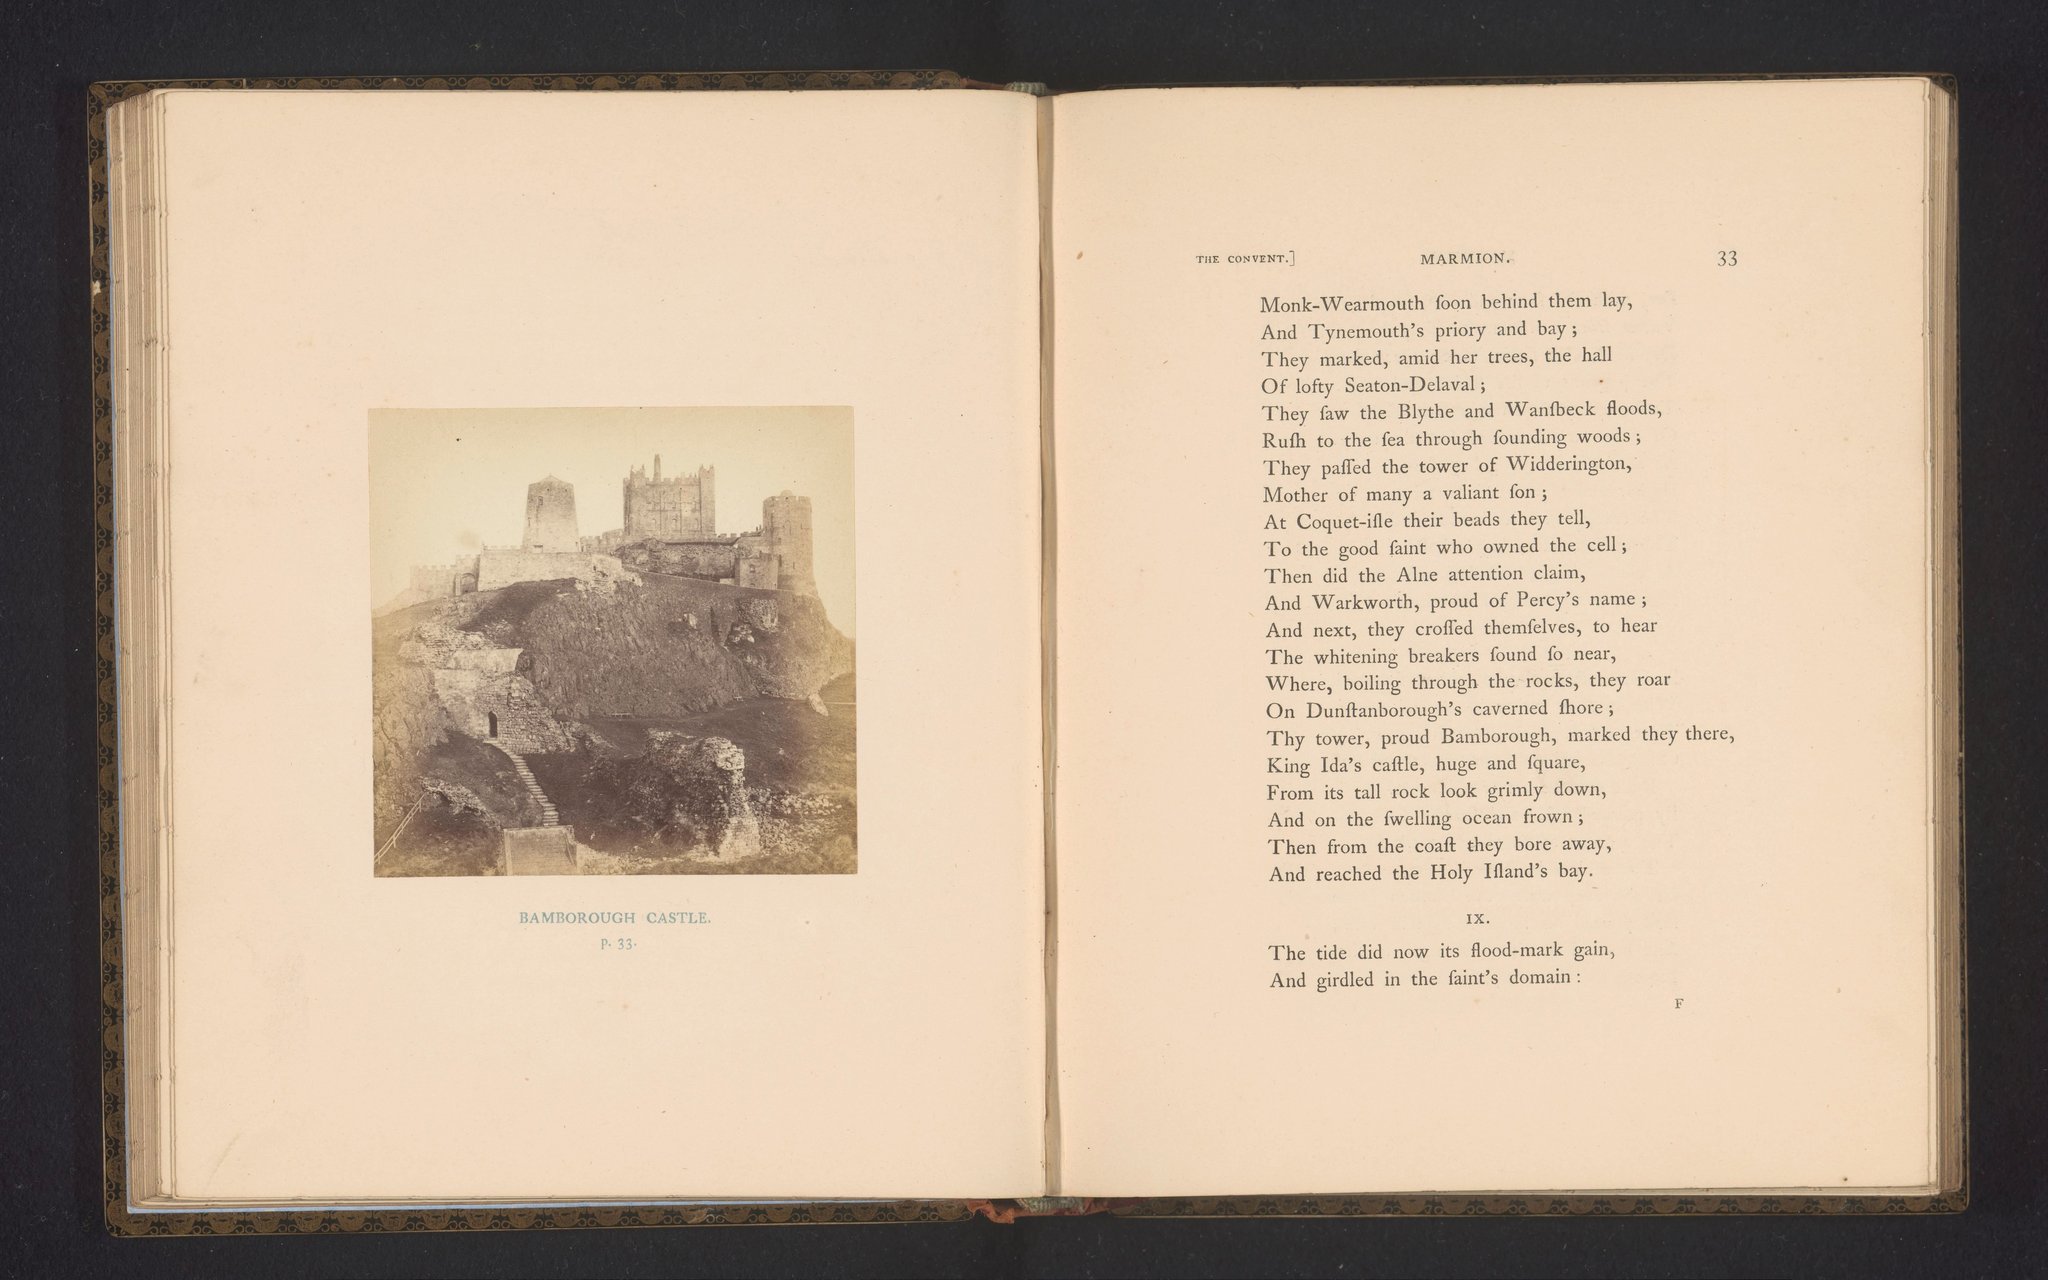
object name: page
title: Bamborough Castle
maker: thomas annan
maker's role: fotograaf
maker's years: 1829-1887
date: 1856-1866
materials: photographic support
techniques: albumen print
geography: northumberland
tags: façade (of house or building), ruin of a dwelling, house, castle, etc.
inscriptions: inscription: ‘p. 33.’